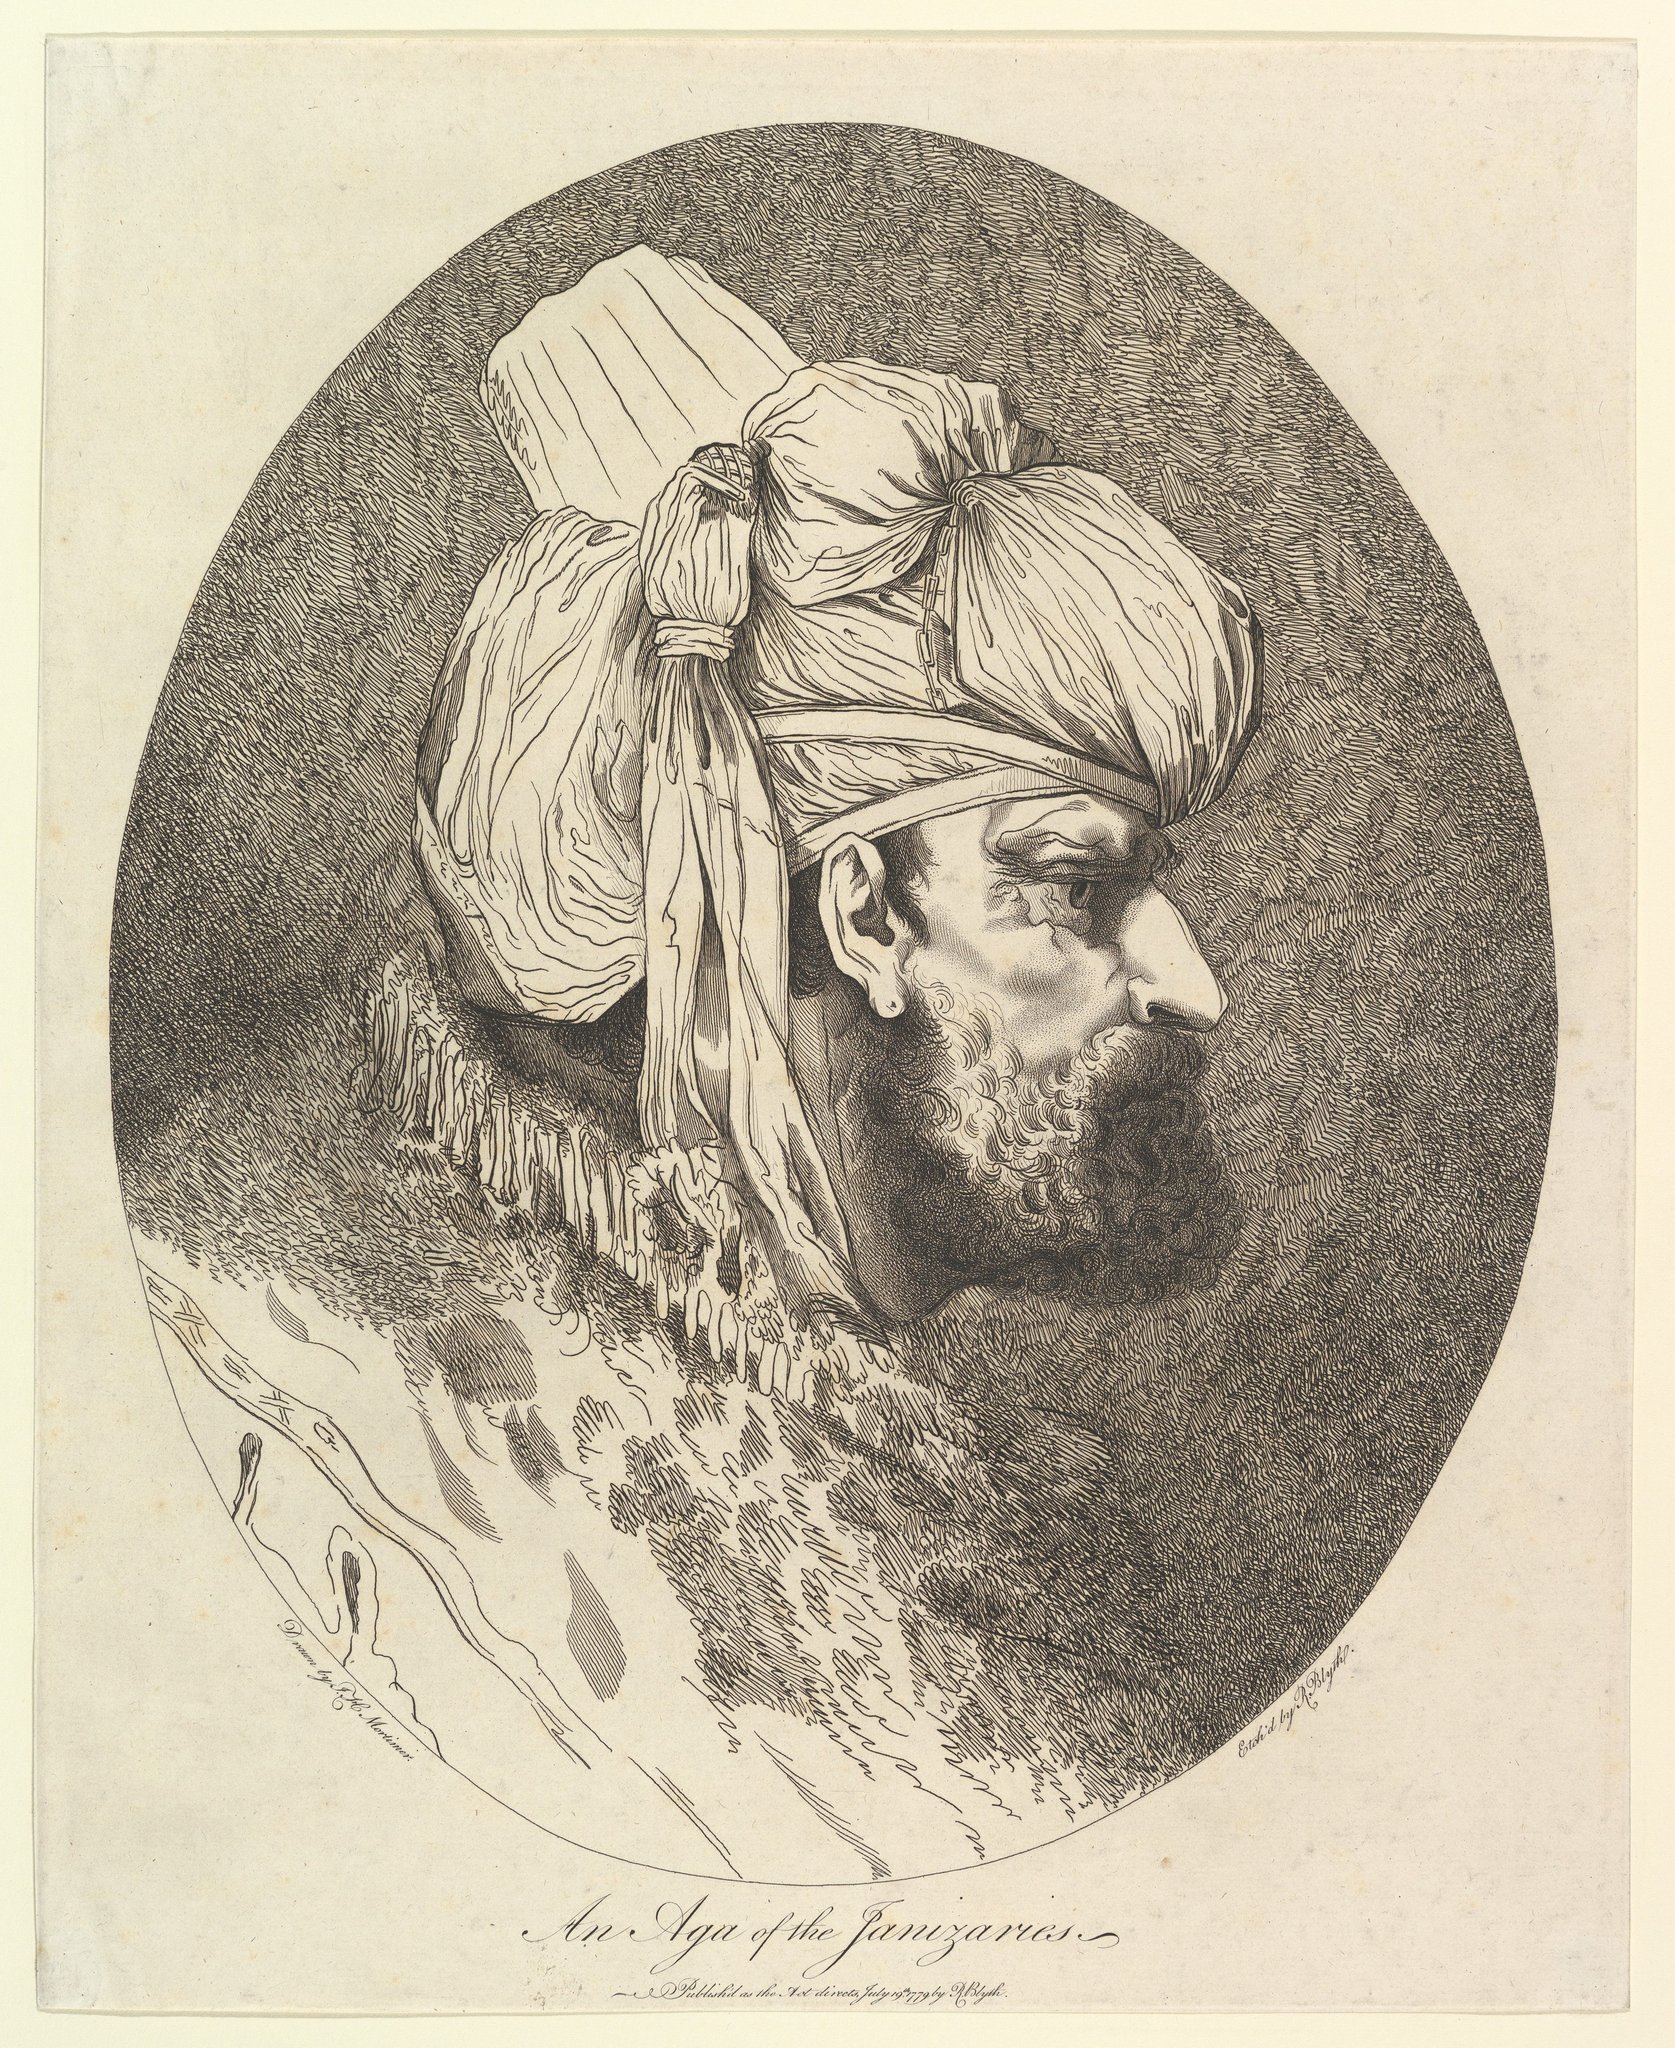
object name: print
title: An Aga of the Janizaries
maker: robert blyth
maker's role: artist and publisher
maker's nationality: british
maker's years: 1750-1784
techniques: etching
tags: men,profiles